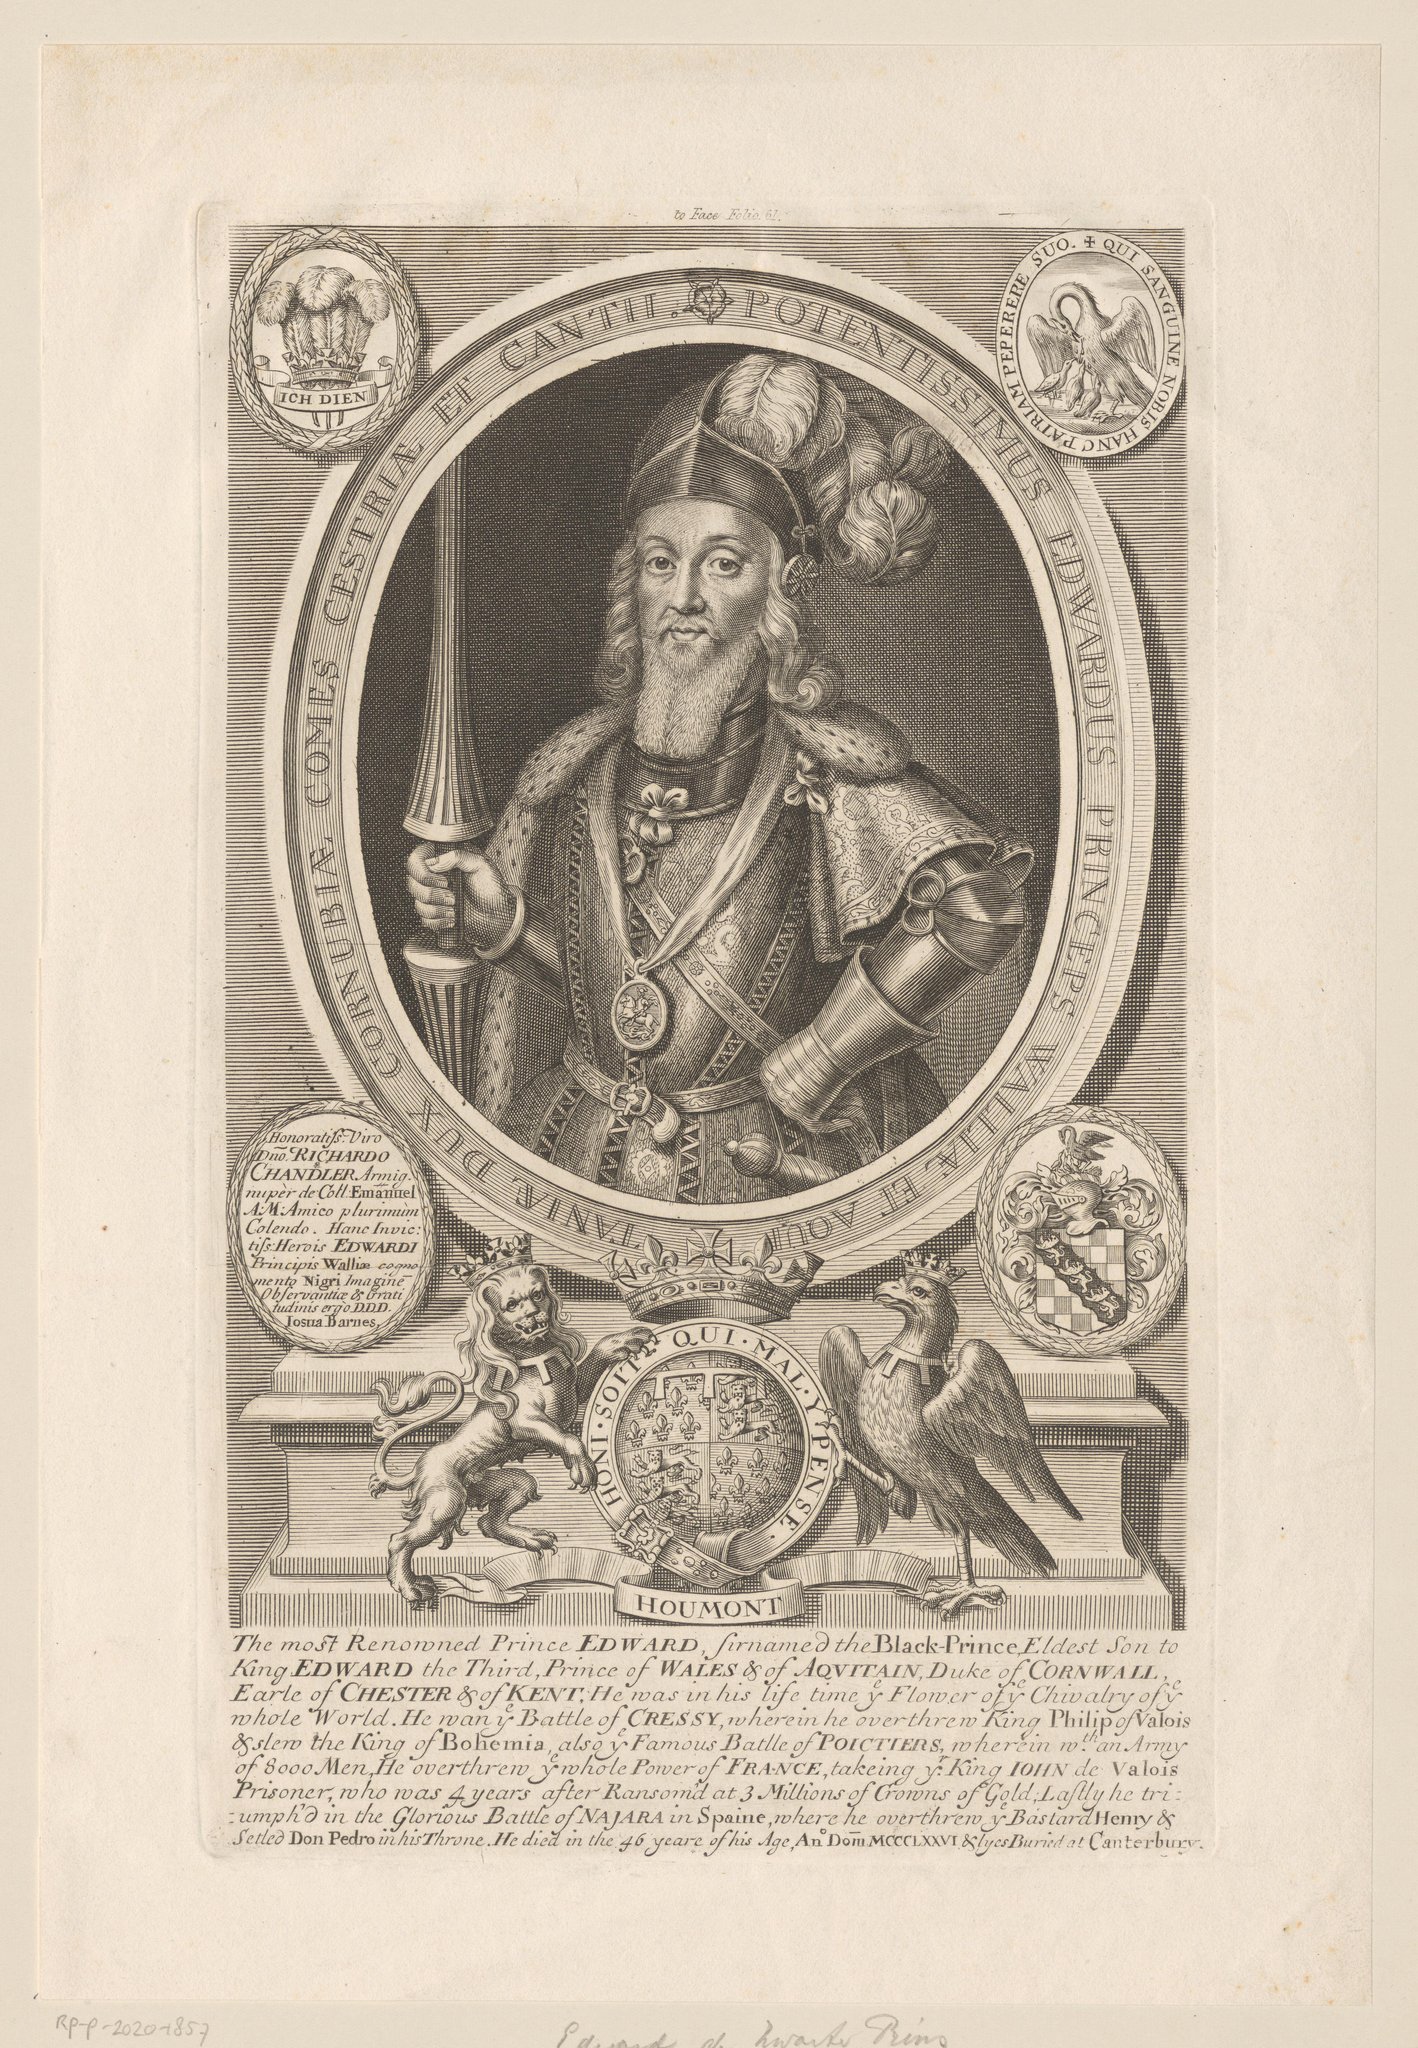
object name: book illustration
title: Portret van Eduard van Woodstock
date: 1688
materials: paper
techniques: engraving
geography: england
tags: armour, historical persons, casting weapons: spear, armorial bearing, heraldry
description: Prent waarschijnlijk uit: Barnes, Joshua. The history of that most victorious monarch Edward IIId (...). Cambridge: John Hayes, 1688.